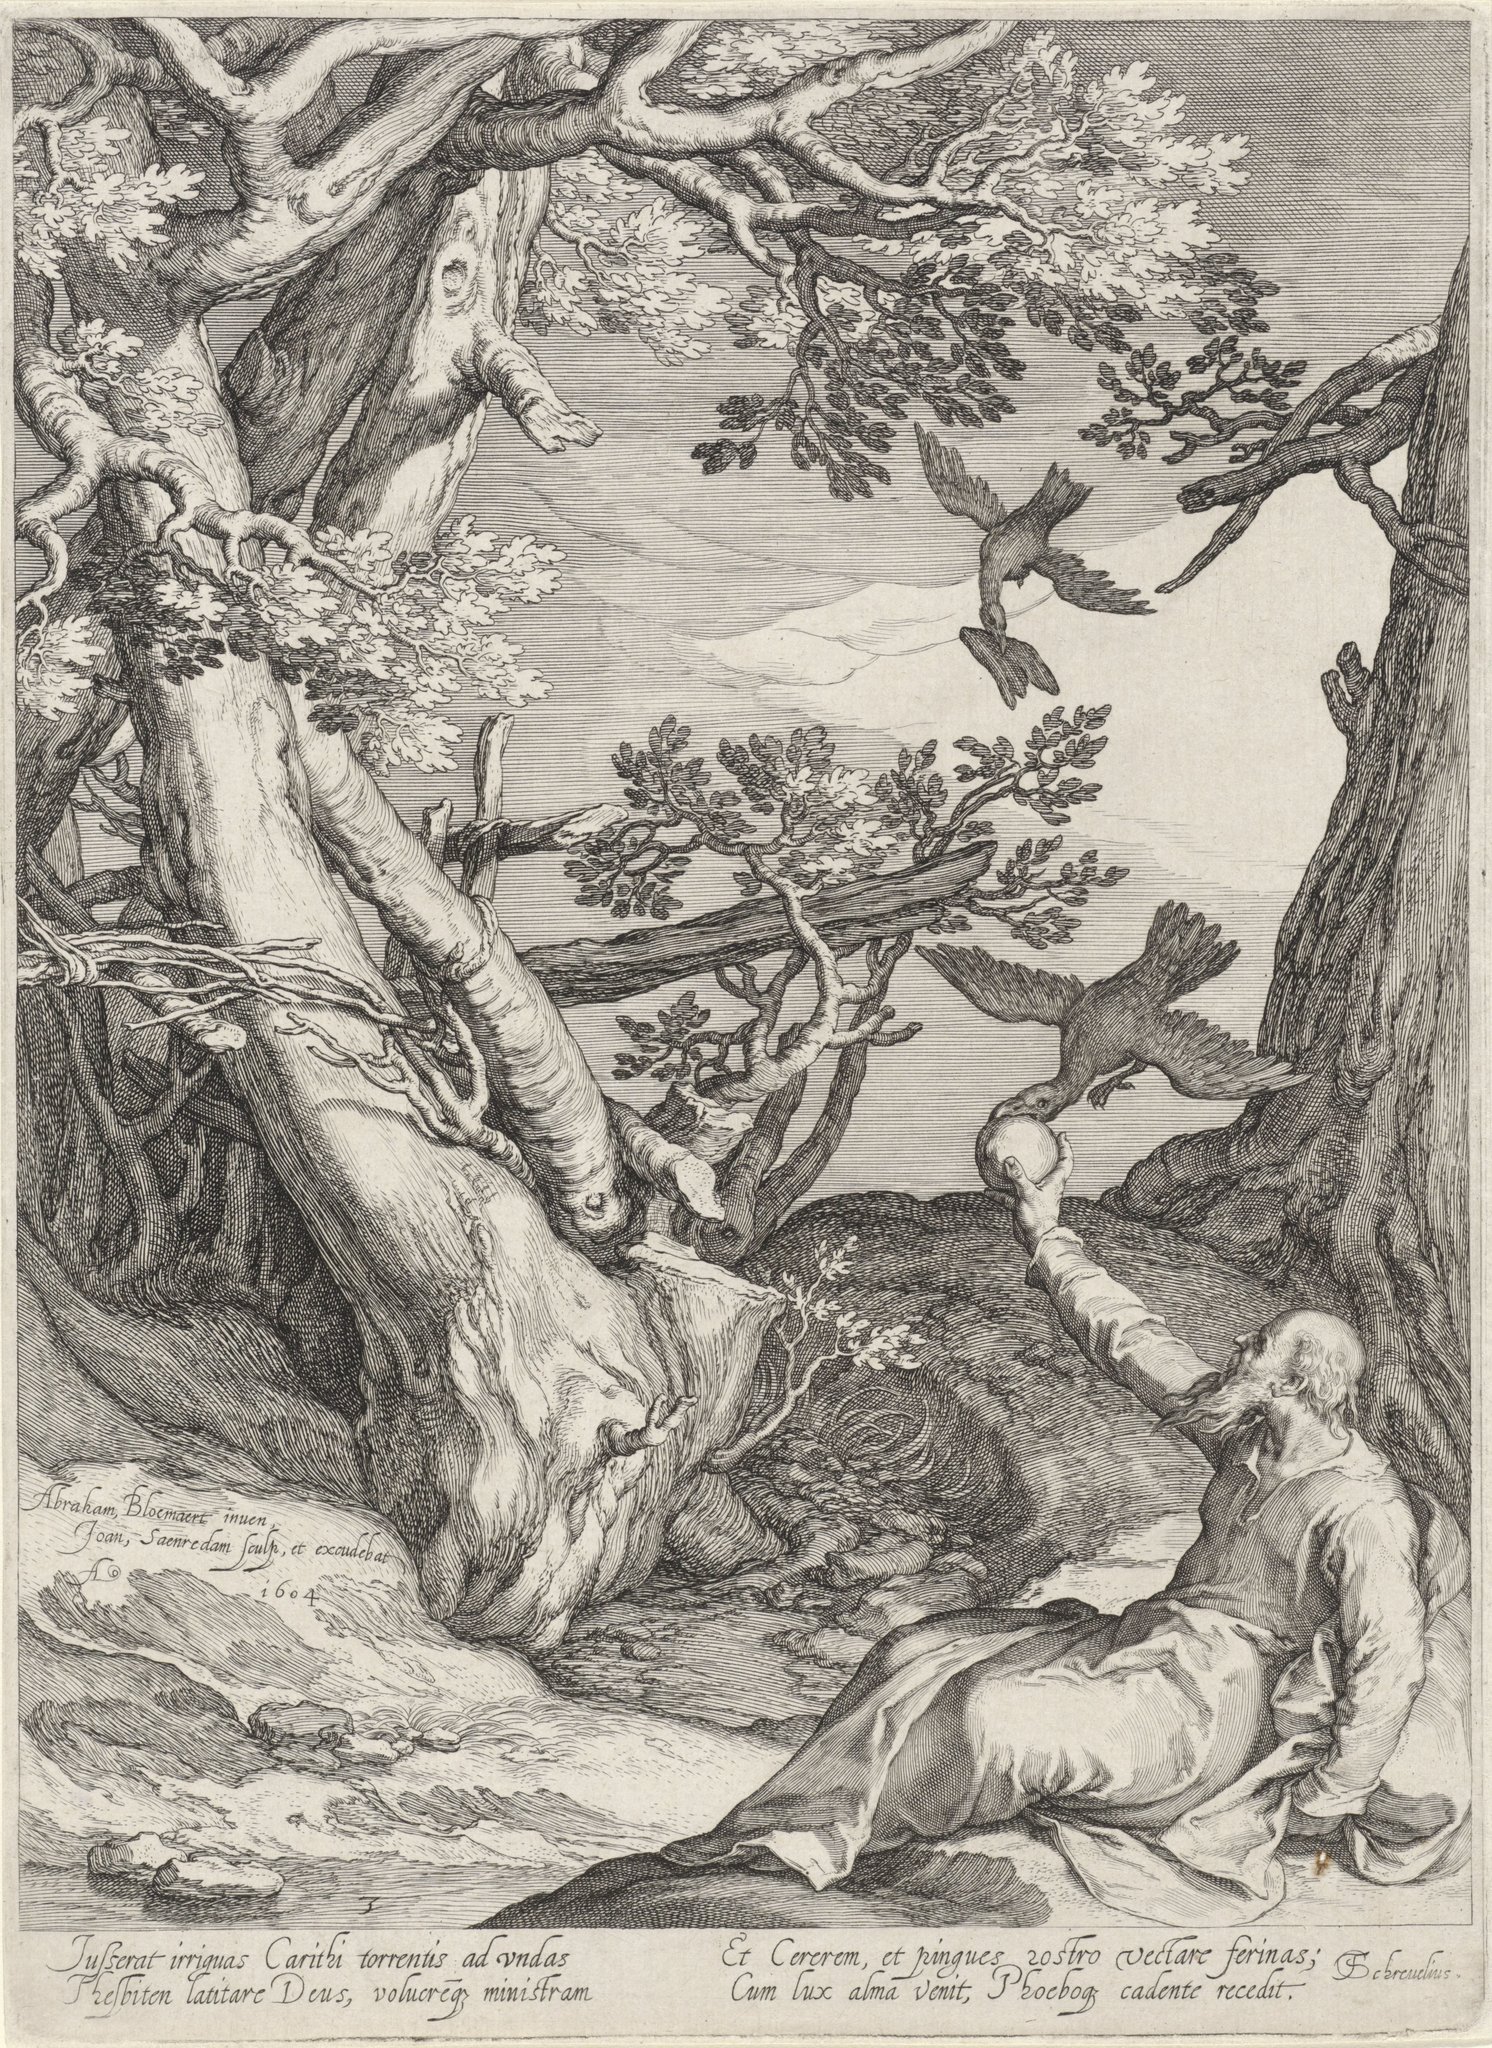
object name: print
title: Vier scènes uit het leven van de profeten Achia en Elia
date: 1604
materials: paper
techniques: engraving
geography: assendelft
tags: elijah fed by the raven(s): while the prophet is living by the brook, ravens bring him food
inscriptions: collector's mark: Lugt 240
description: De profeet Elia zit op de grond in de wildernis. Twee raven komen hem voedsel brengen. De prent heeft een Latijnse tekst in de ondermarge.